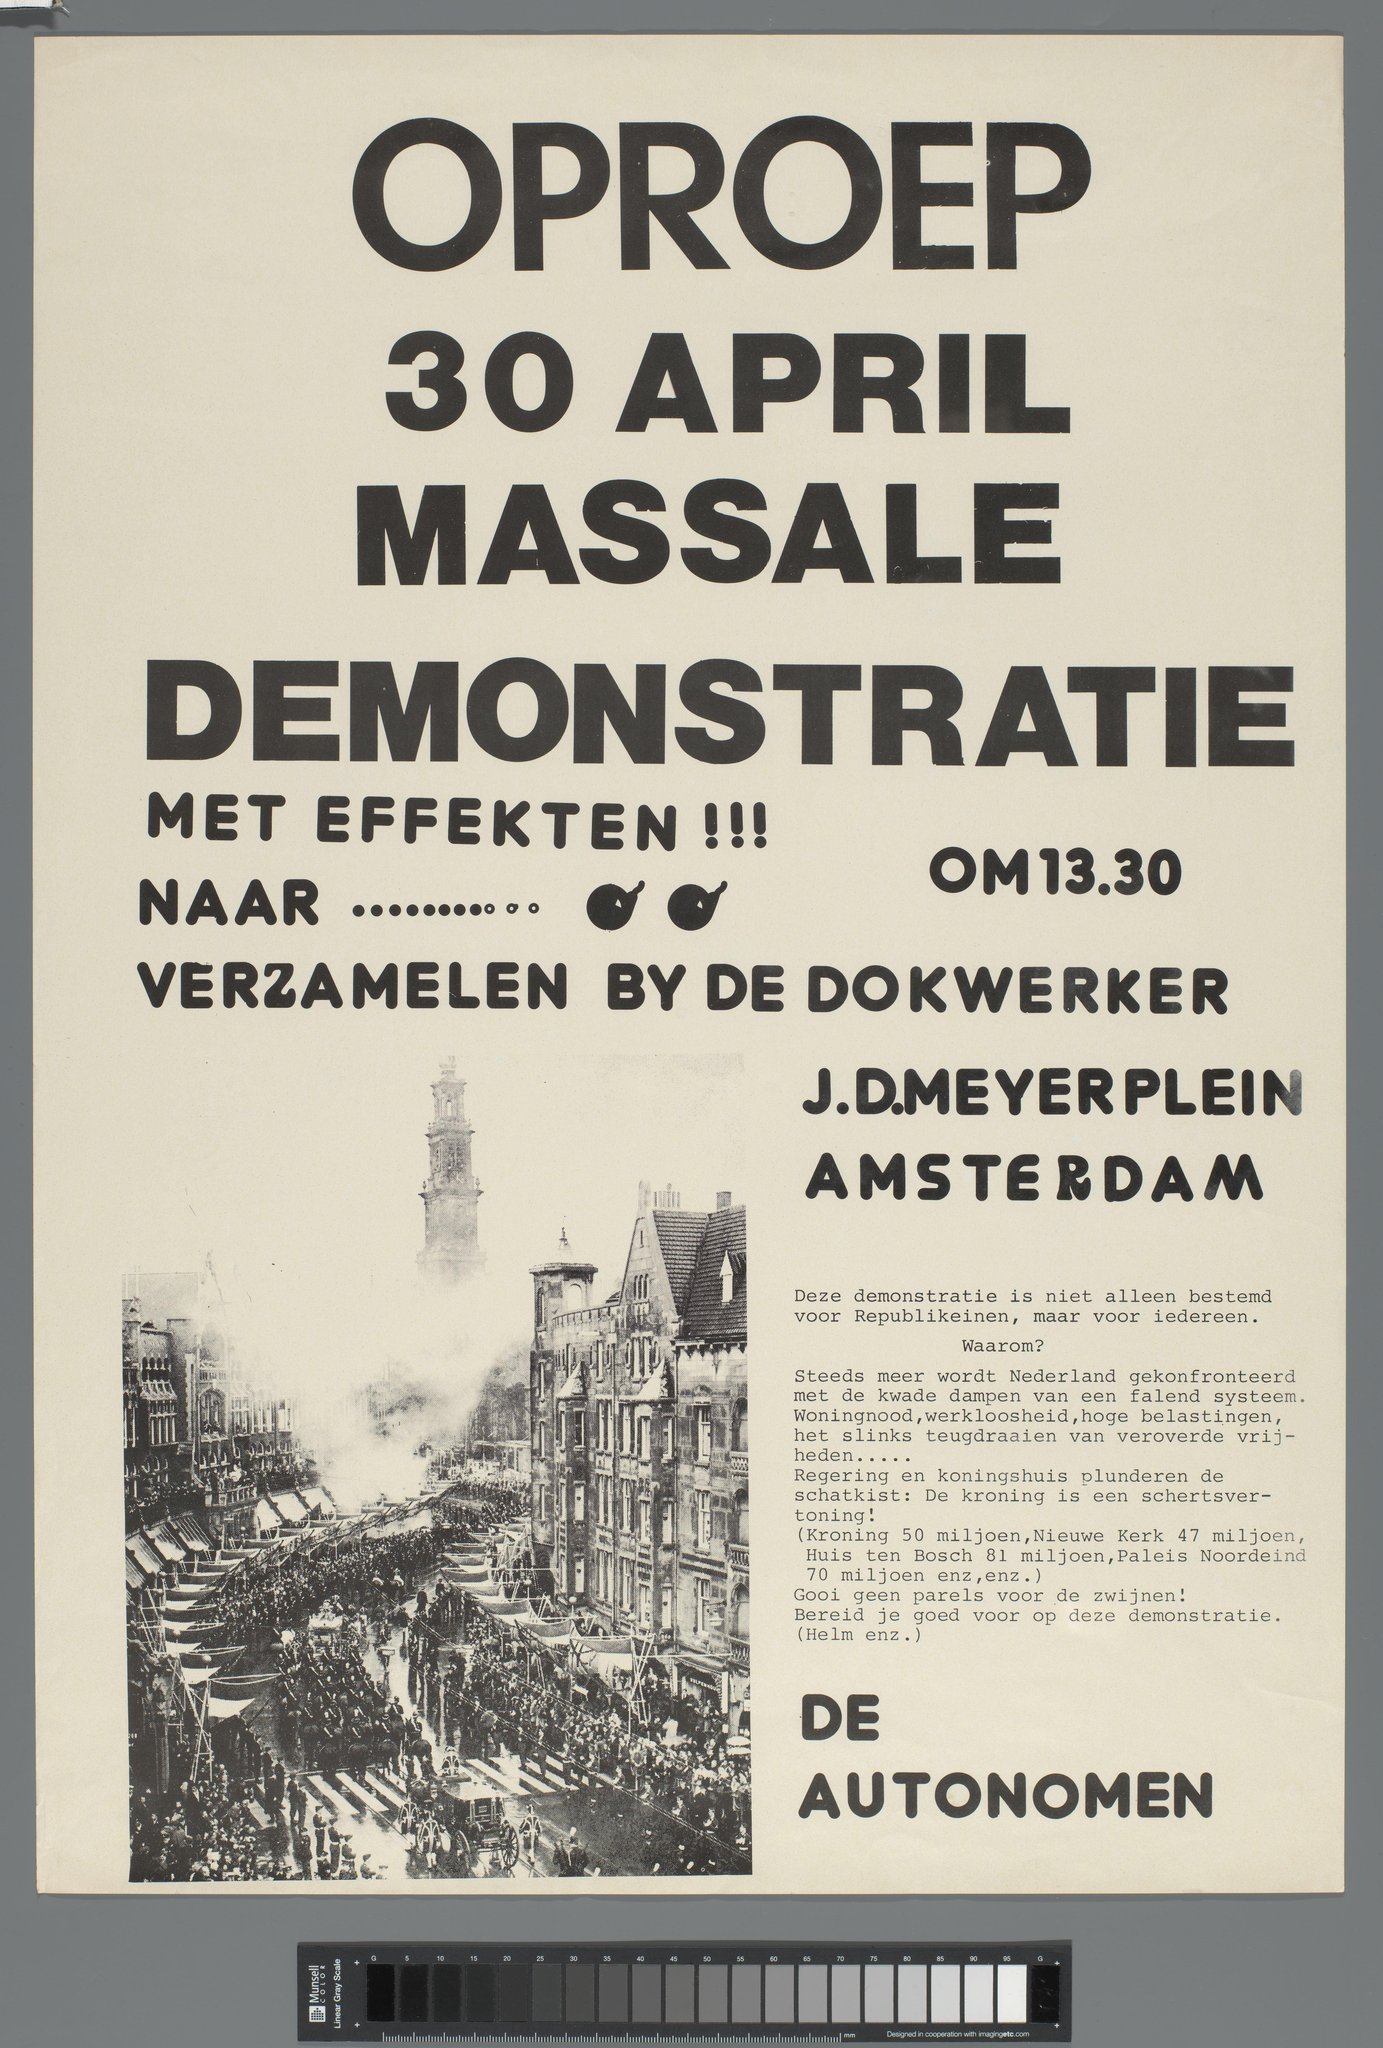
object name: poster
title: Oproep 30 April Massale Demonstratie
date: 1904-1980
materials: paper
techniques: printing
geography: amsterdam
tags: beatrix (koningin der nederlanden), amsterdam, inauguration of beatrix as queen of the netherlands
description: Aanplakbiljet, deels oranje-gekleurd, met tekst en afbeeldingen, gericht tegen de inhuldiging van koningin Beatrix en de maatregelen daarmee in verband in Amsterdam genomen, uitgegeven door de 'kraakbeweging' en anarchisten ed.